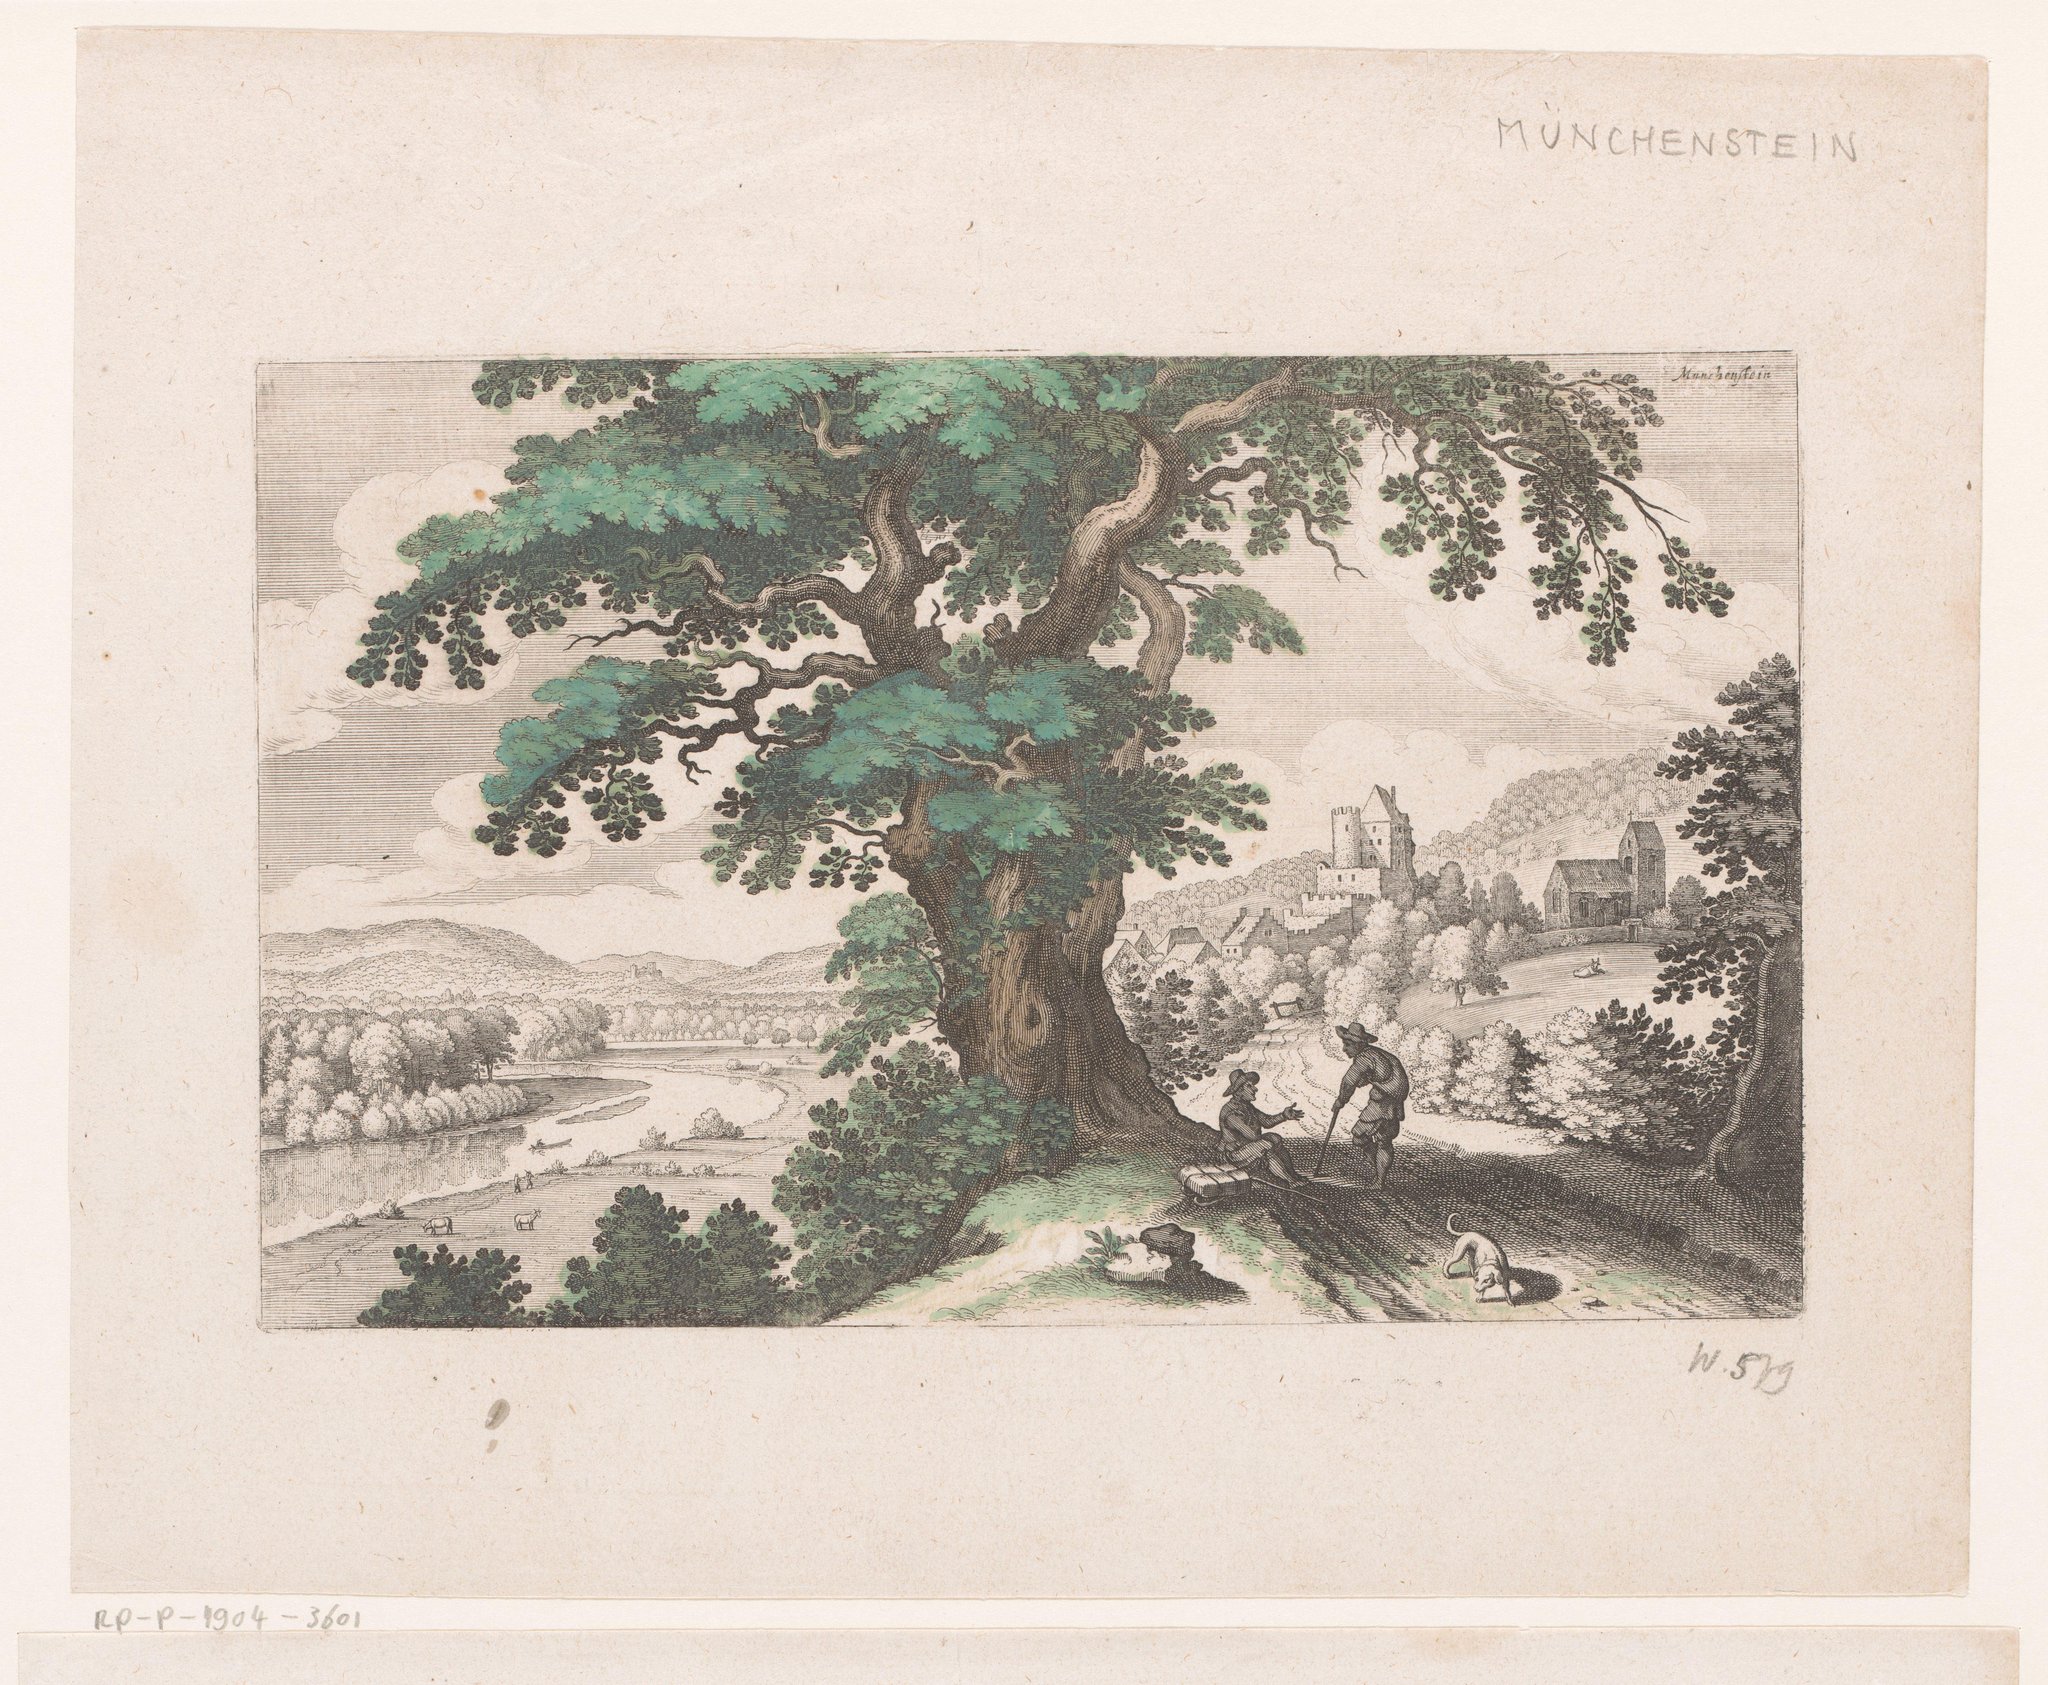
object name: print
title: Landschappen met jachtscènes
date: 1624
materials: paper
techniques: etching, hand coloring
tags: city-view, and landscape with man-made constructions, castle, river (+ landscape with figures, staffage)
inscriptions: collector's mark: Lugt 2228